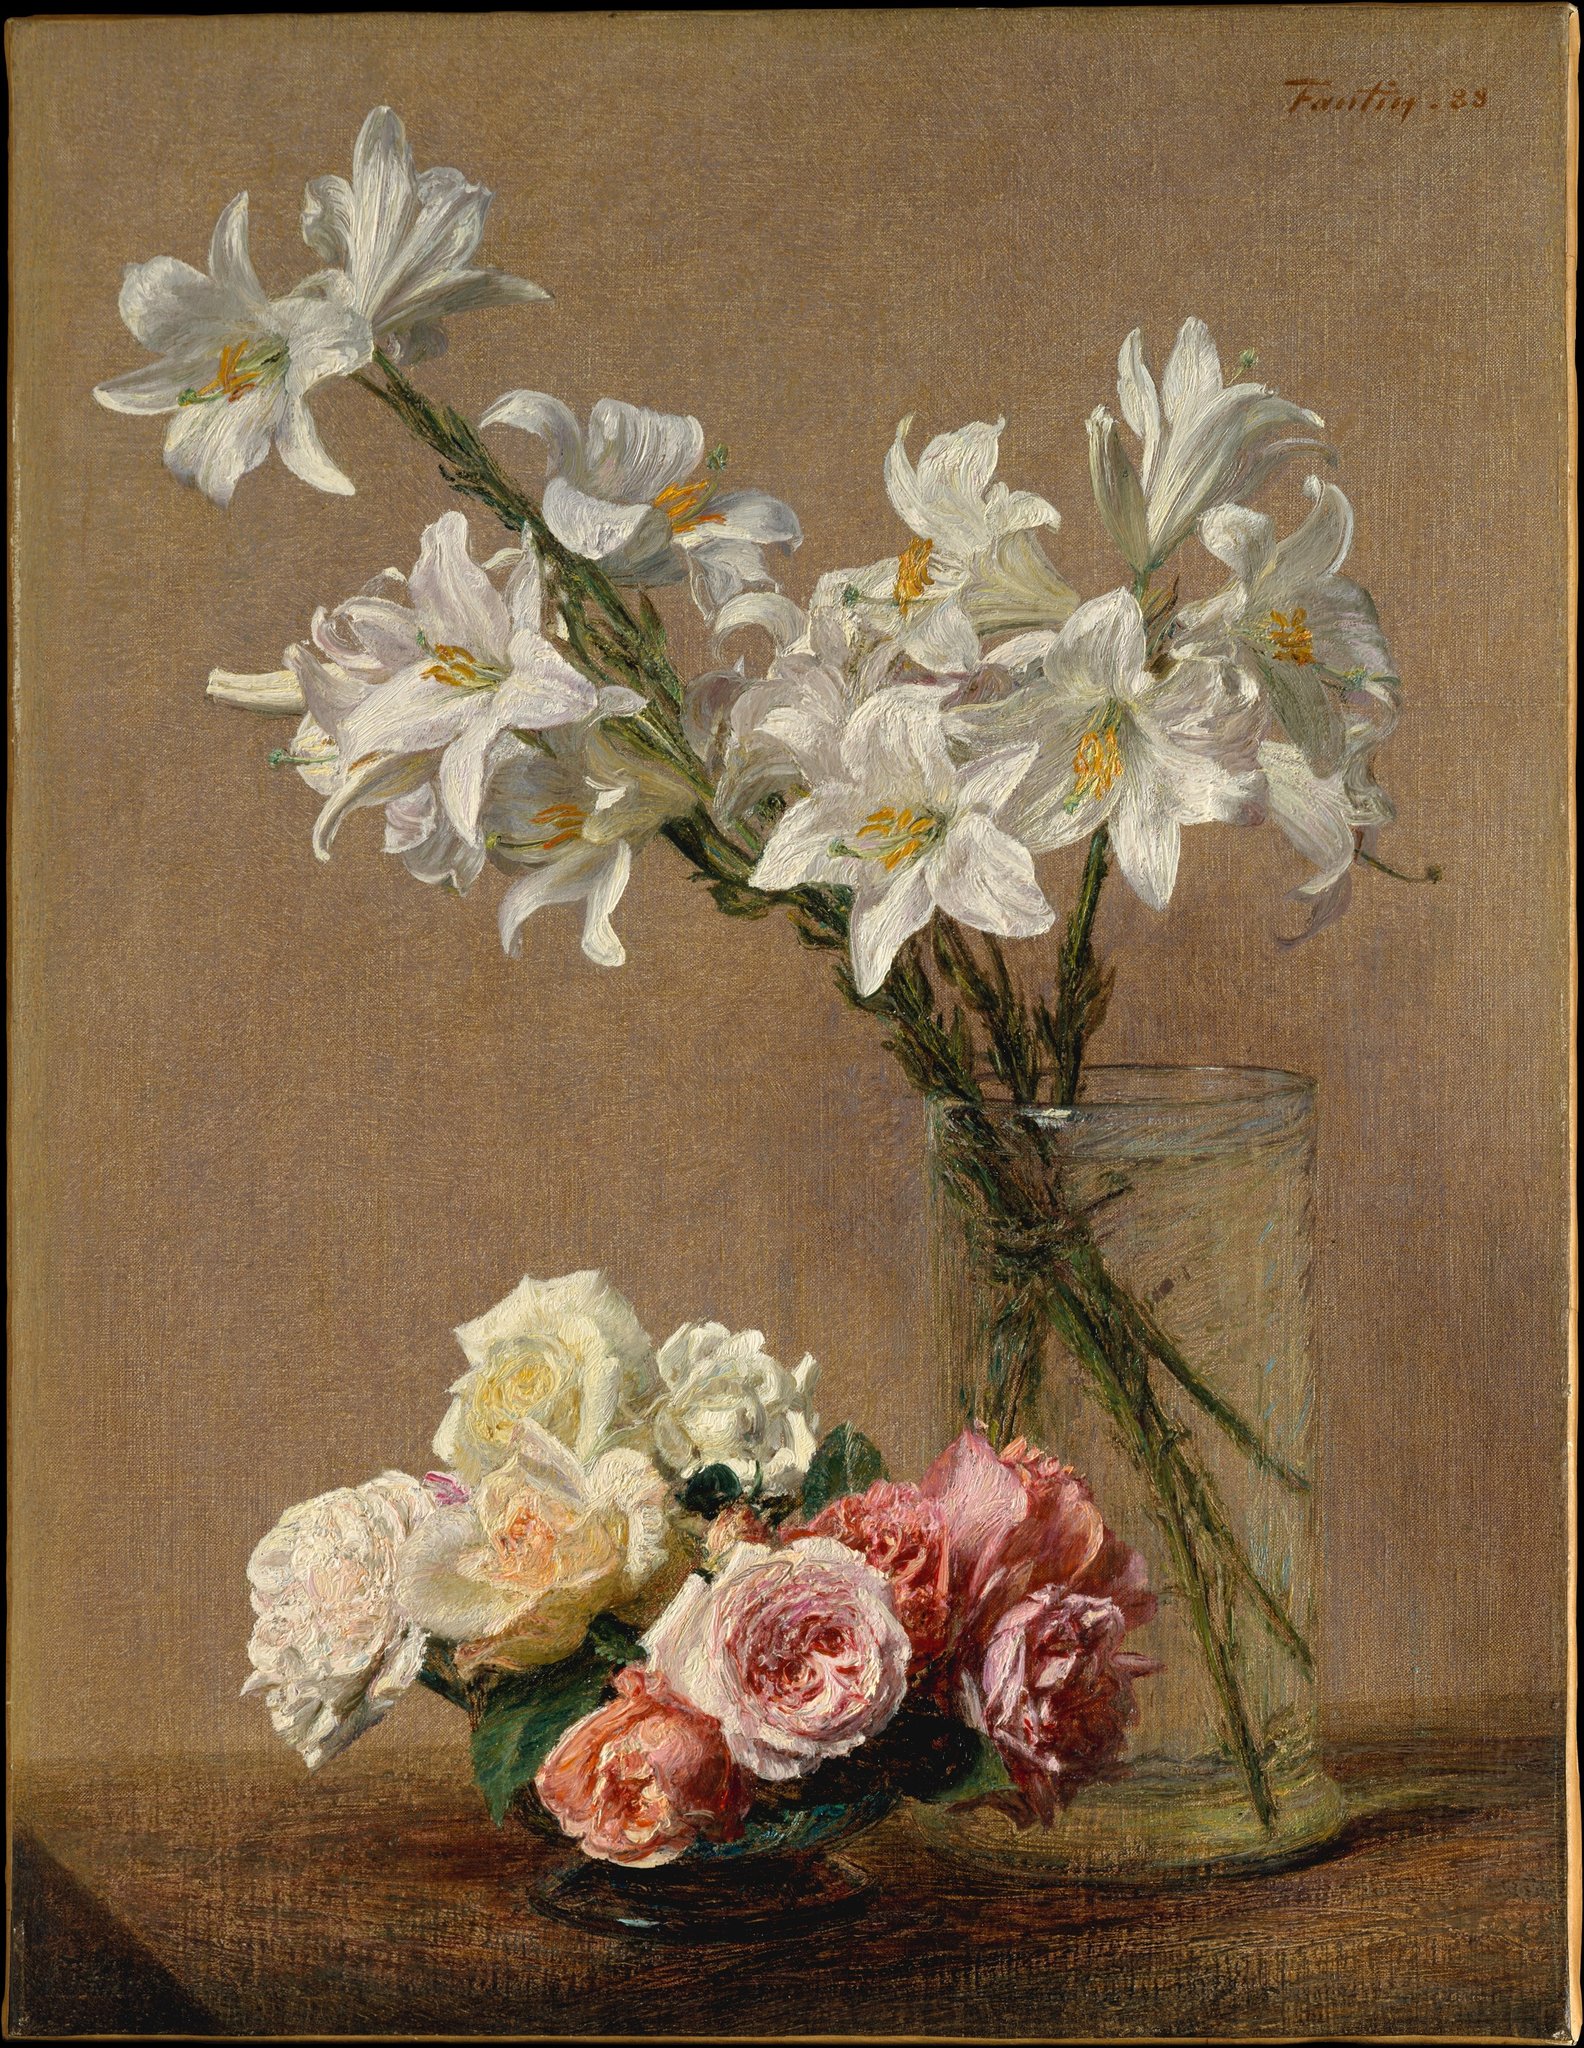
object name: painting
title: Roses and Lilies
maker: henri fantin-latour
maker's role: artist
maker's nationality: french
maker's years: 1836-1904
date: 1888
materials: canvas, oil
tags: lilies,roses,still life